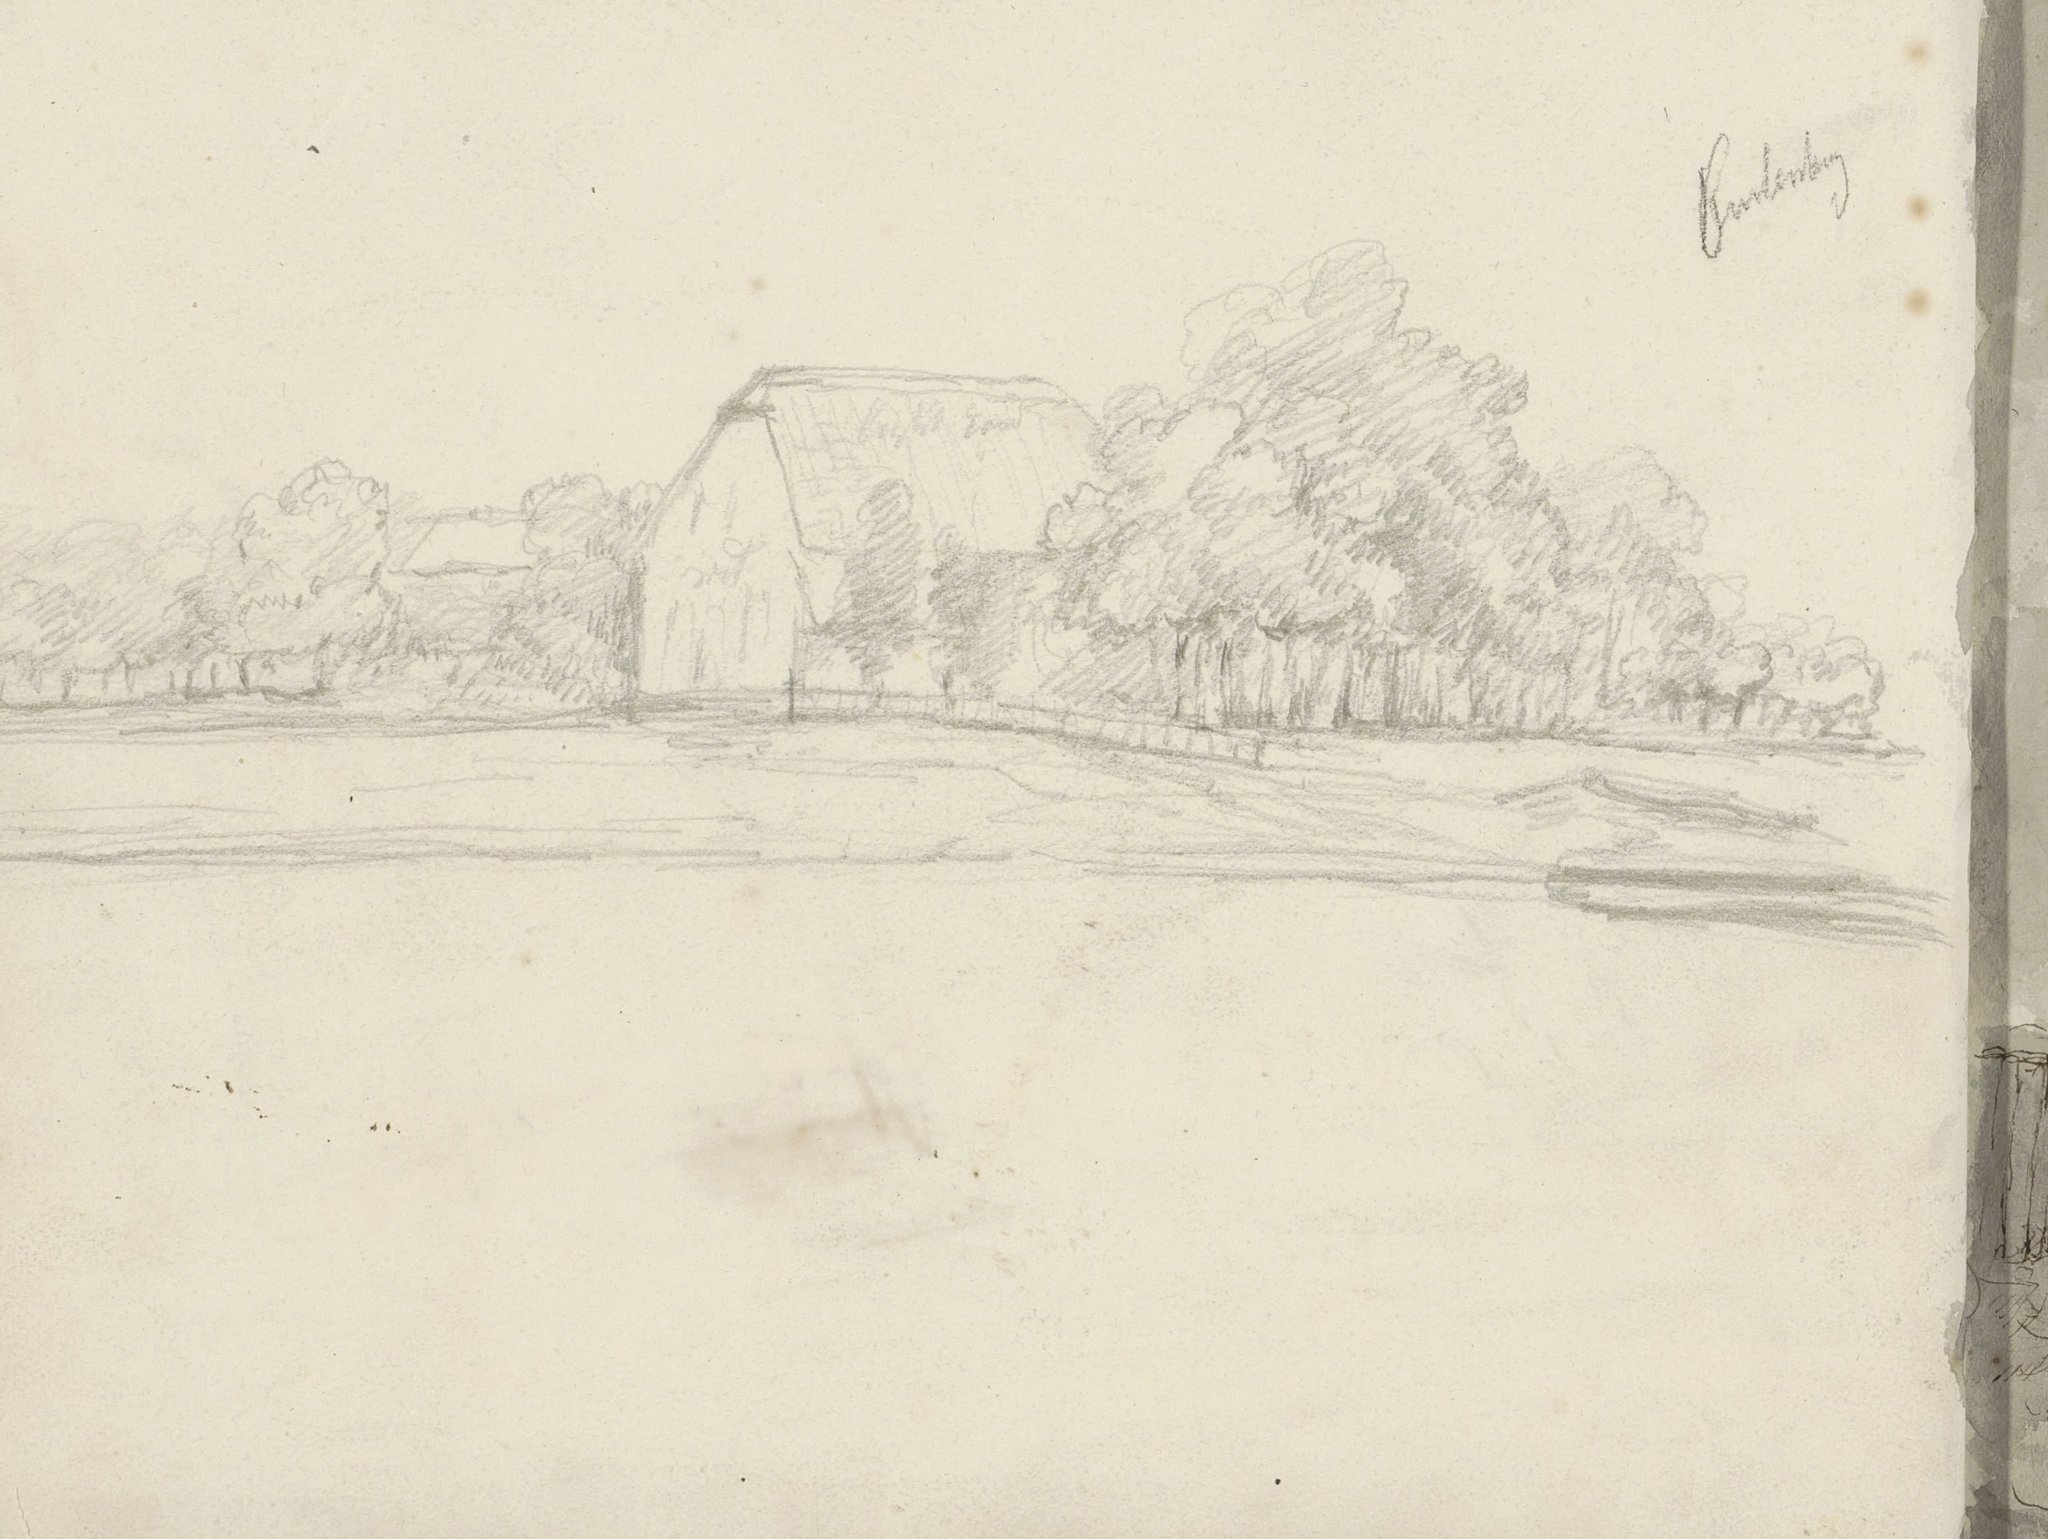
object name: sketchbook leaf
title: Landschap te Rustenburg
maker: petrus johannes schotel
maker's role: draughtsman, painter, print maker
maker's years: 1808-1865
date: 1825-1875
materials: paper, pencil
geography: rustenburg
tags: farm or solitary house in landscape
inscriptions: annotation: ‘Rustenburg’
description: Blad 7 verso uit een schetsboek met 44 bladen.